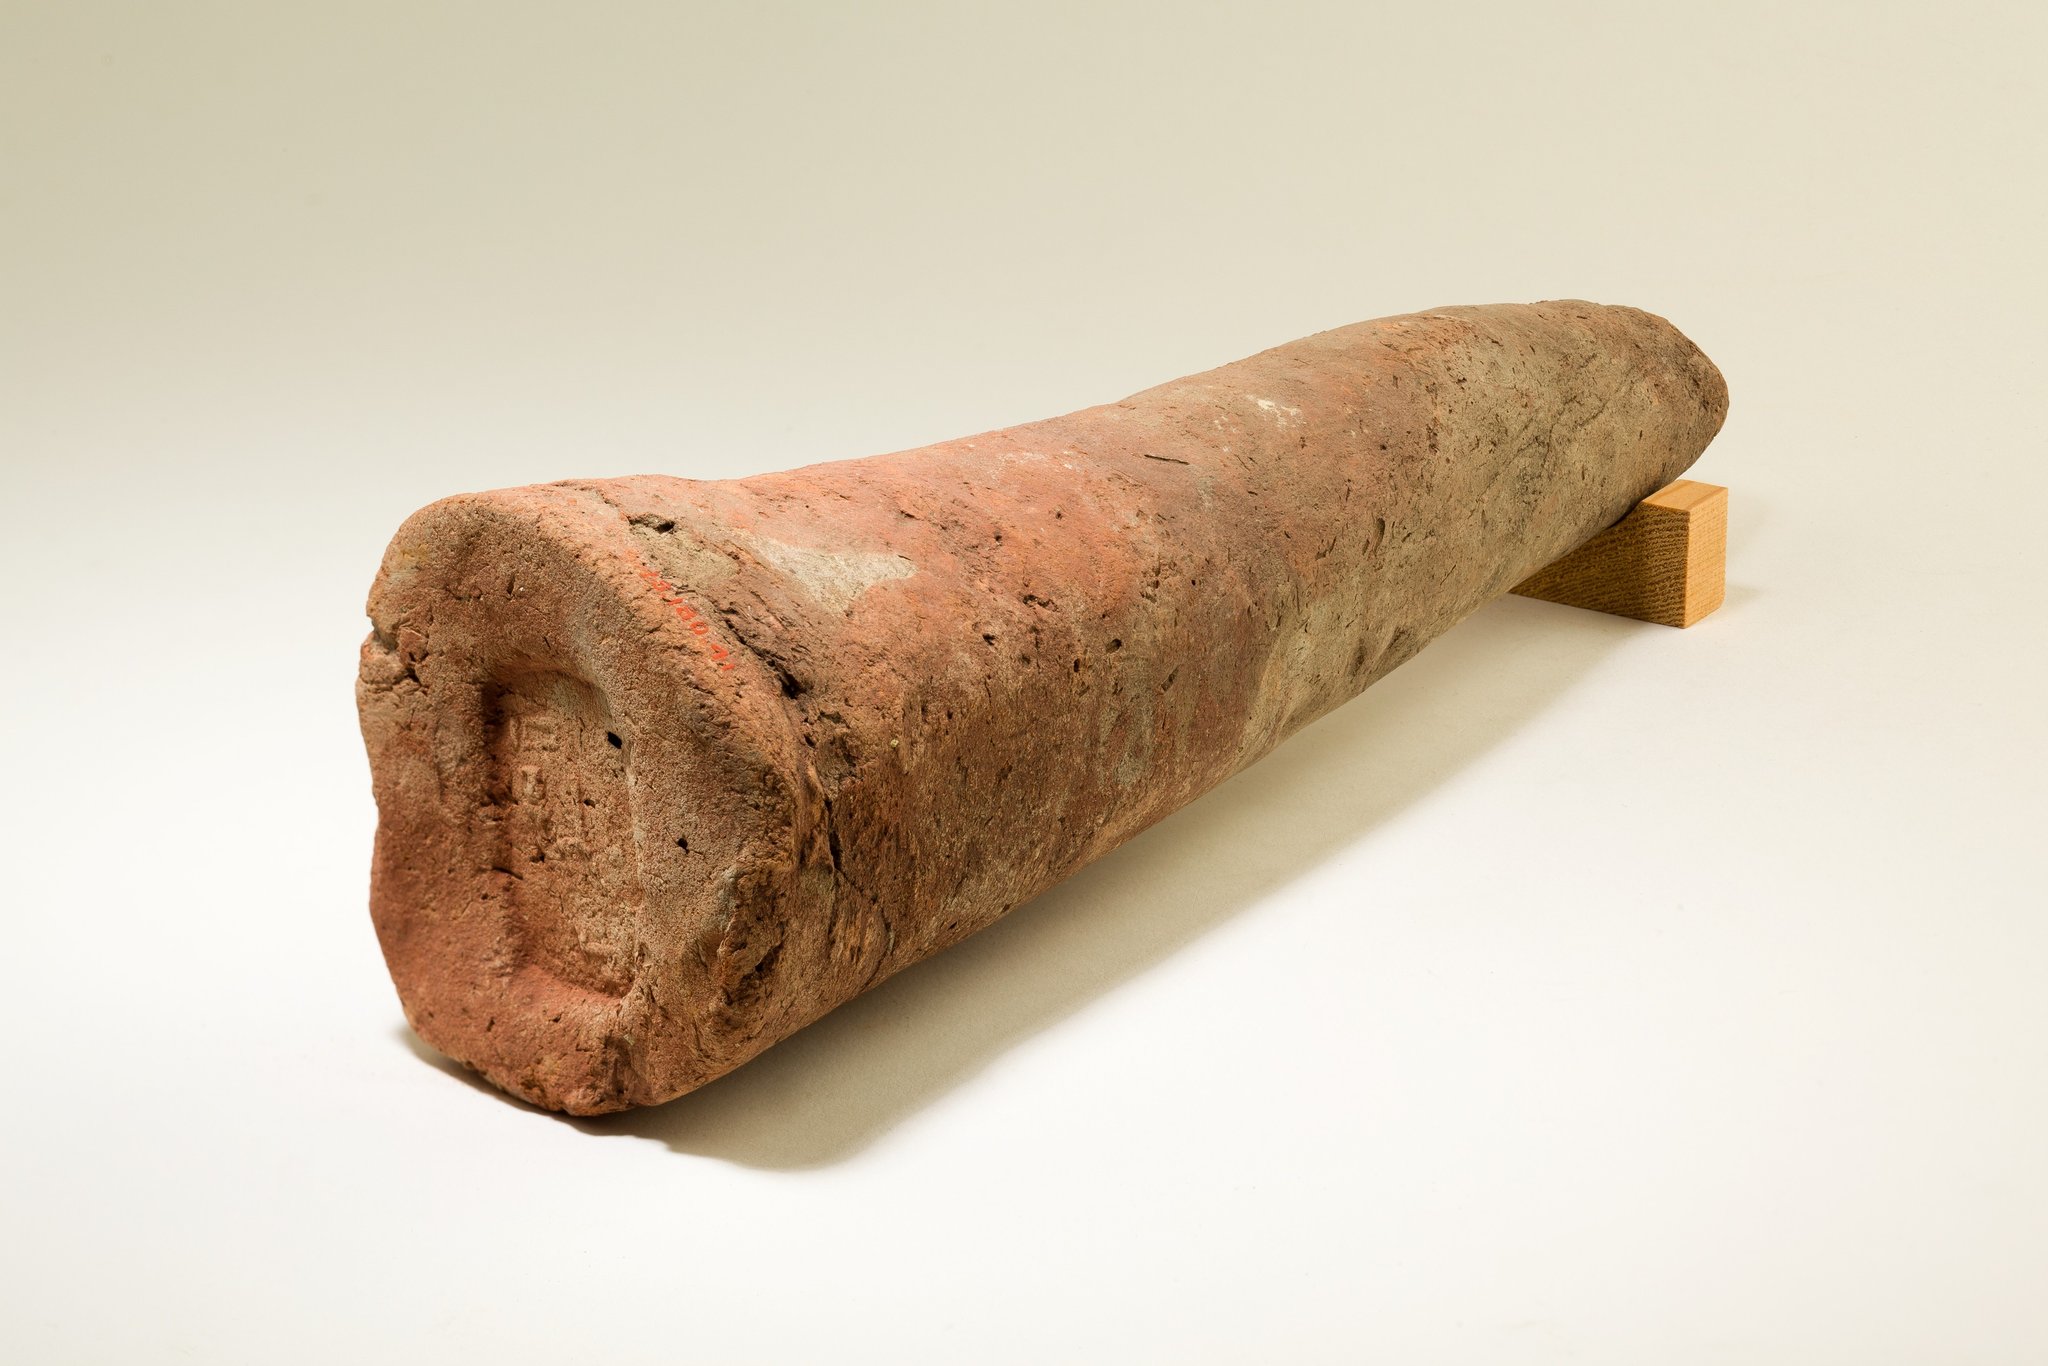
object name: cone, oval impression, abekh, steward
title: Funerary Cone of the Steward Abekh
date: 1550-1295 BCE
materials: pottery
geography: egypt